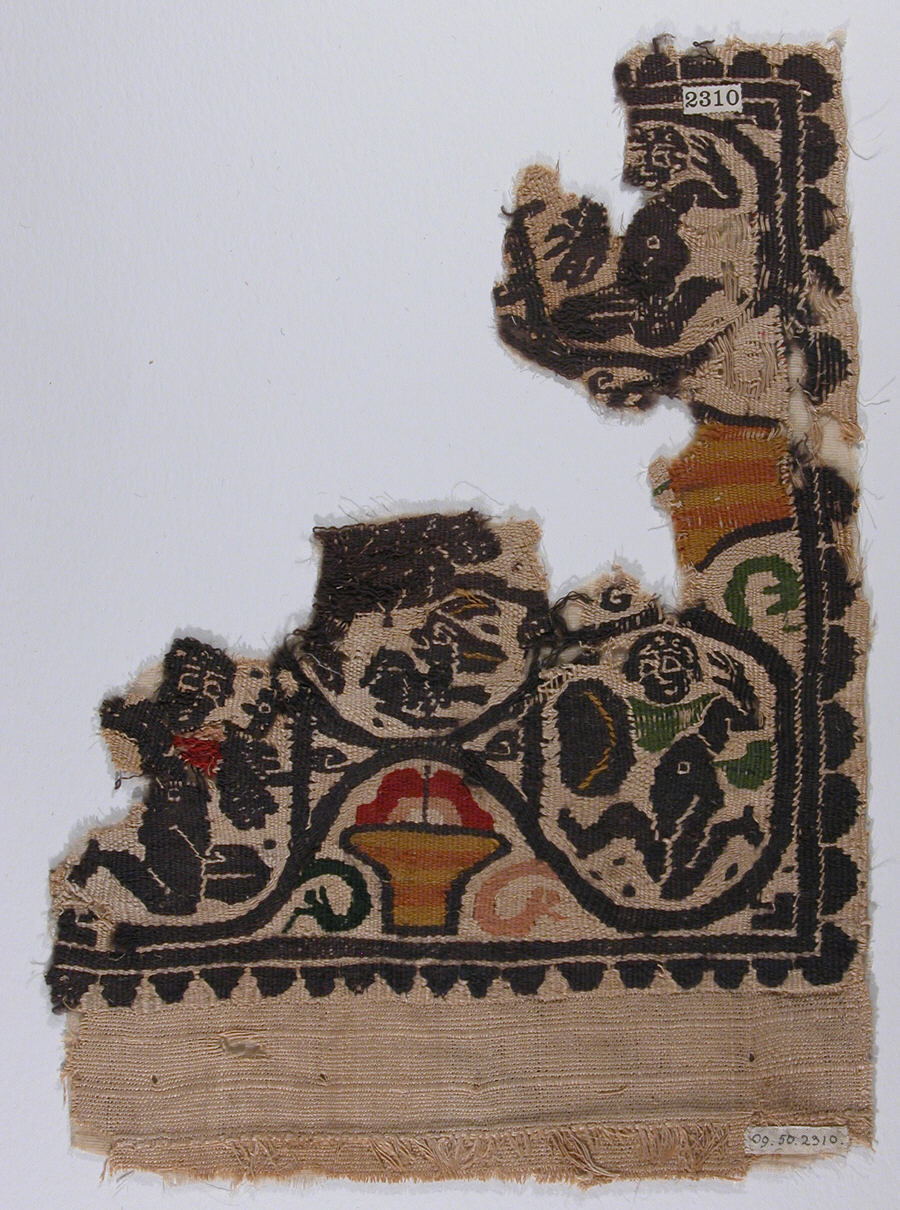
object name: textile fragment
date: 301-500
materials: linen, wool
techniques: weave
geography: egypt